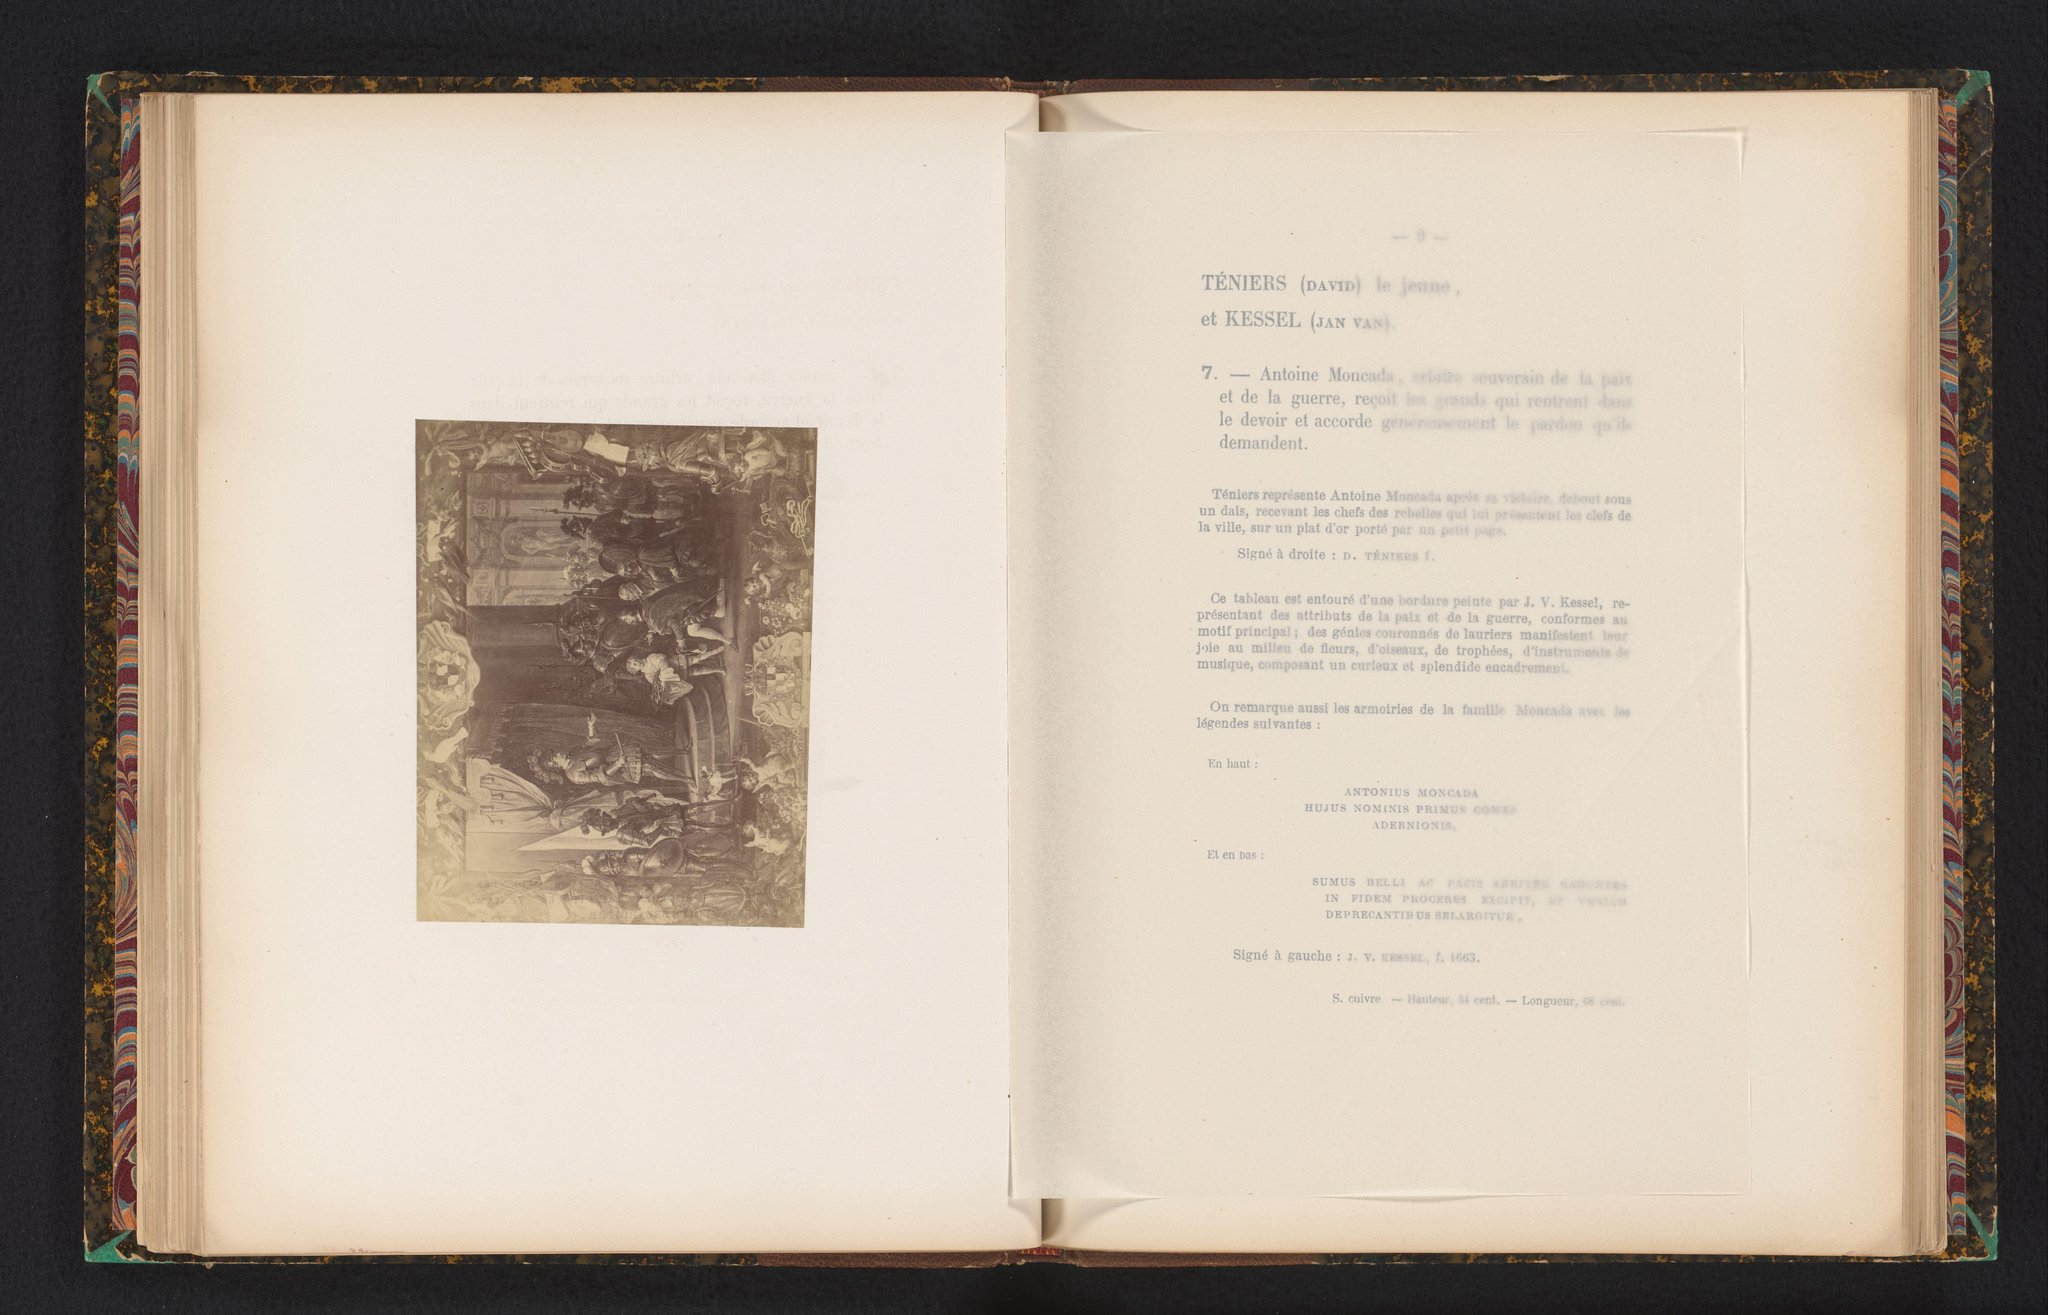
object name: photograph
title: Fotoreproductie van een schilderij van Antonius Moncada die de opstandelingen ontvangt na zijn overwinning, door David Teniers en Jan van Kessel I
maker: Anonymous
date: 1865-1870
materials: photographic support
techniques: albumen print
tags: audition; ruler giving audience